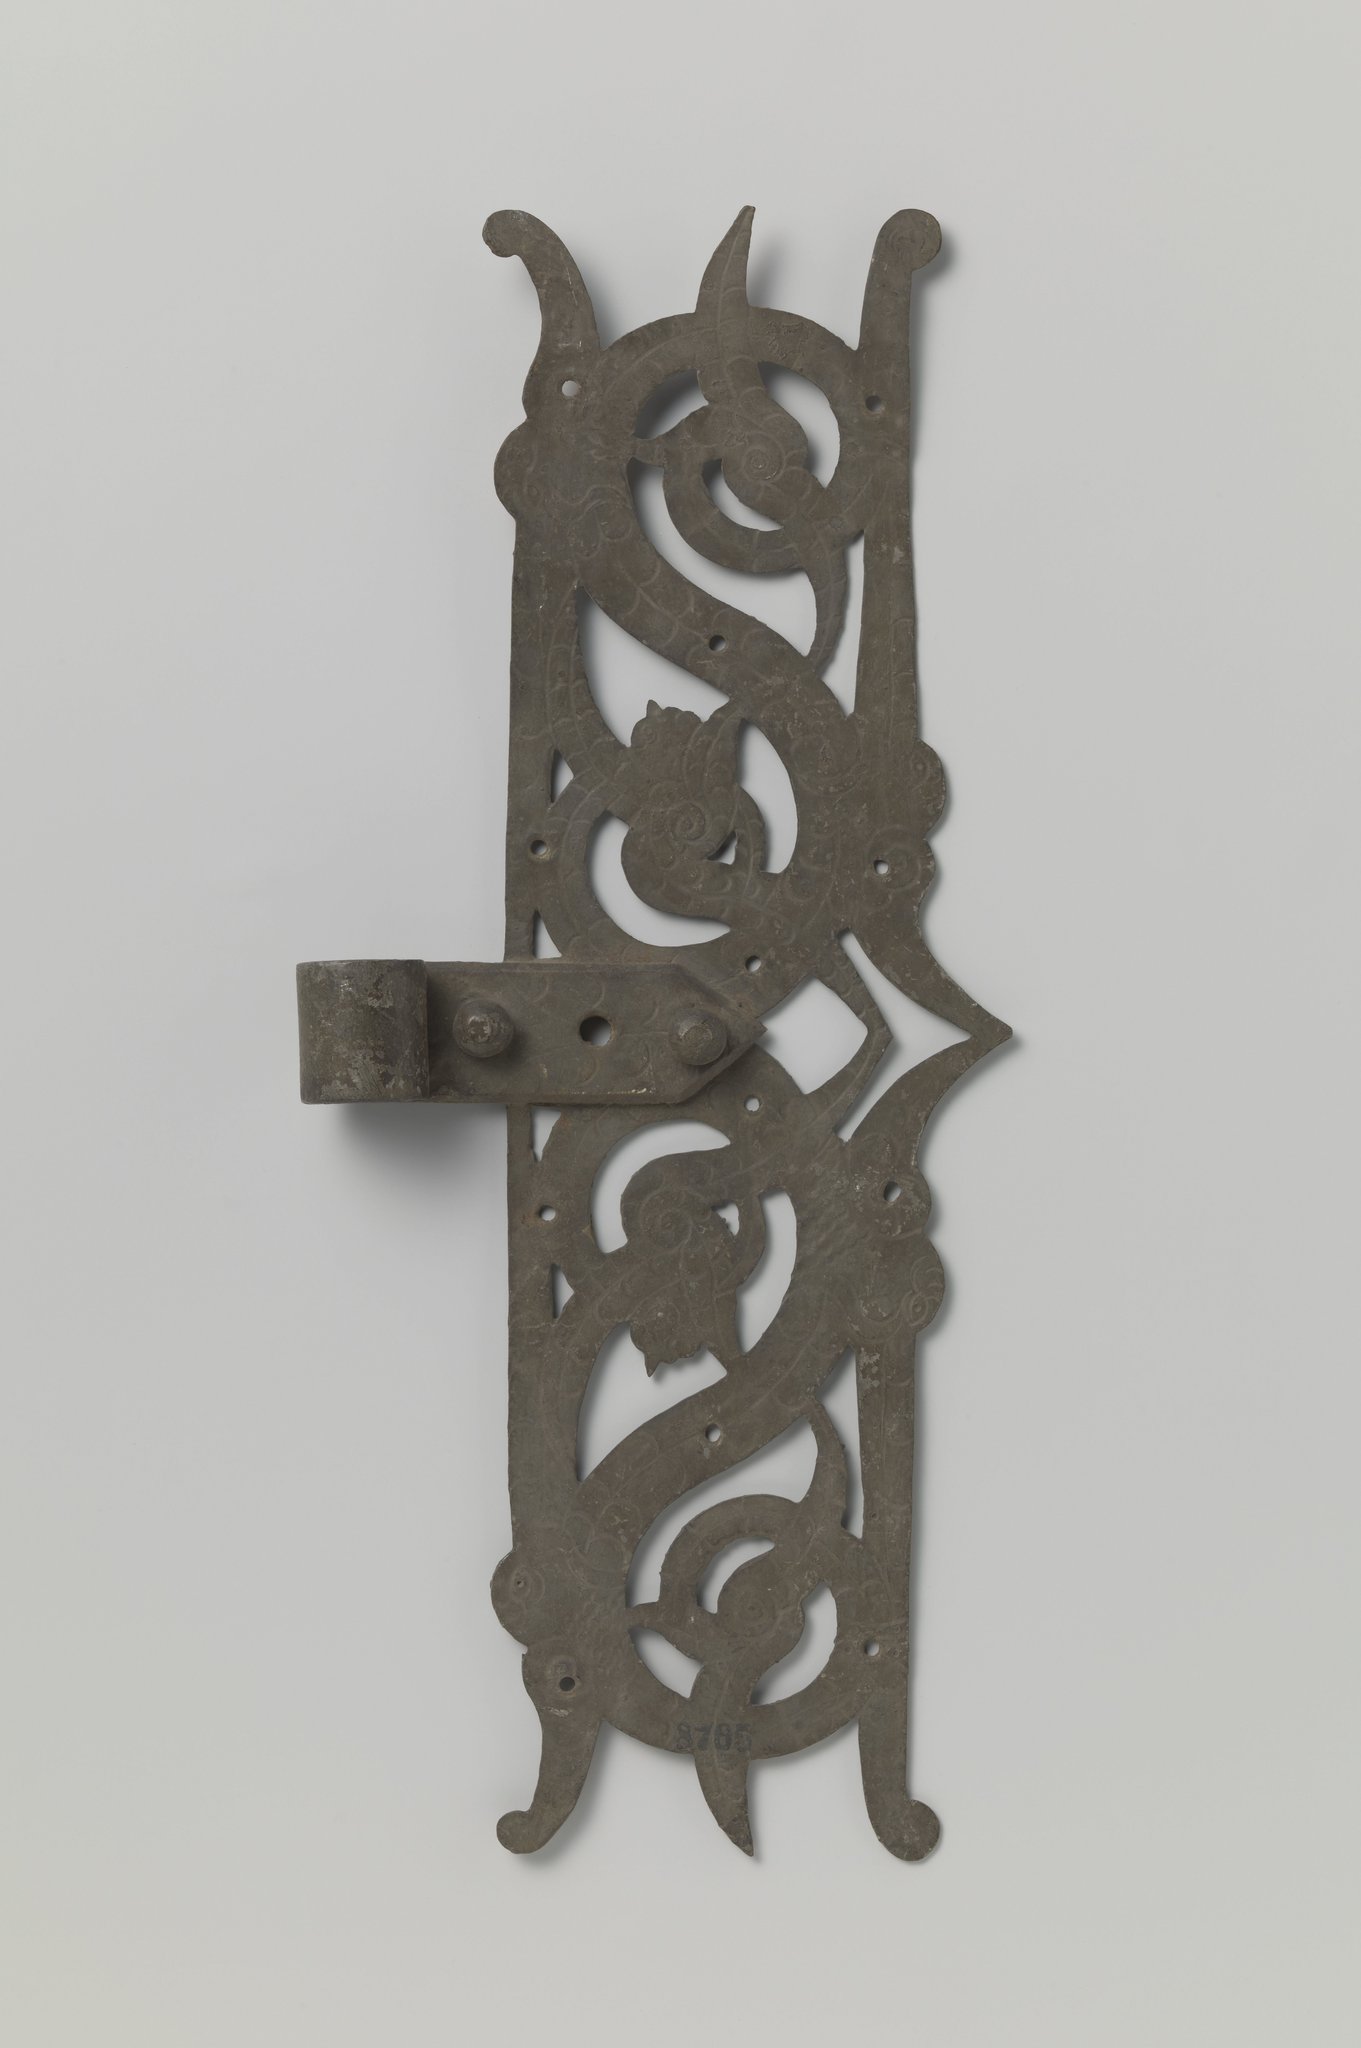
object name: hengsel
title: Hengsel van vertind ijzer met rankmotieven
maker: Anonymous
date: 1600-1700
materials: iron, tin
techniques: metalworking, tinning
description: Hengsel van vertind ijzer. Onderaan een grote, ronde opening van een scharnier met daaraan een rechte aanzet. Achter de aanzet bevindt zich het opengewerkte, symmetrische beslag met rankmotieven in voluut tussen twee rechtere banen. De bovenste baan loopt in het midden toe in een opengewerkte punt.